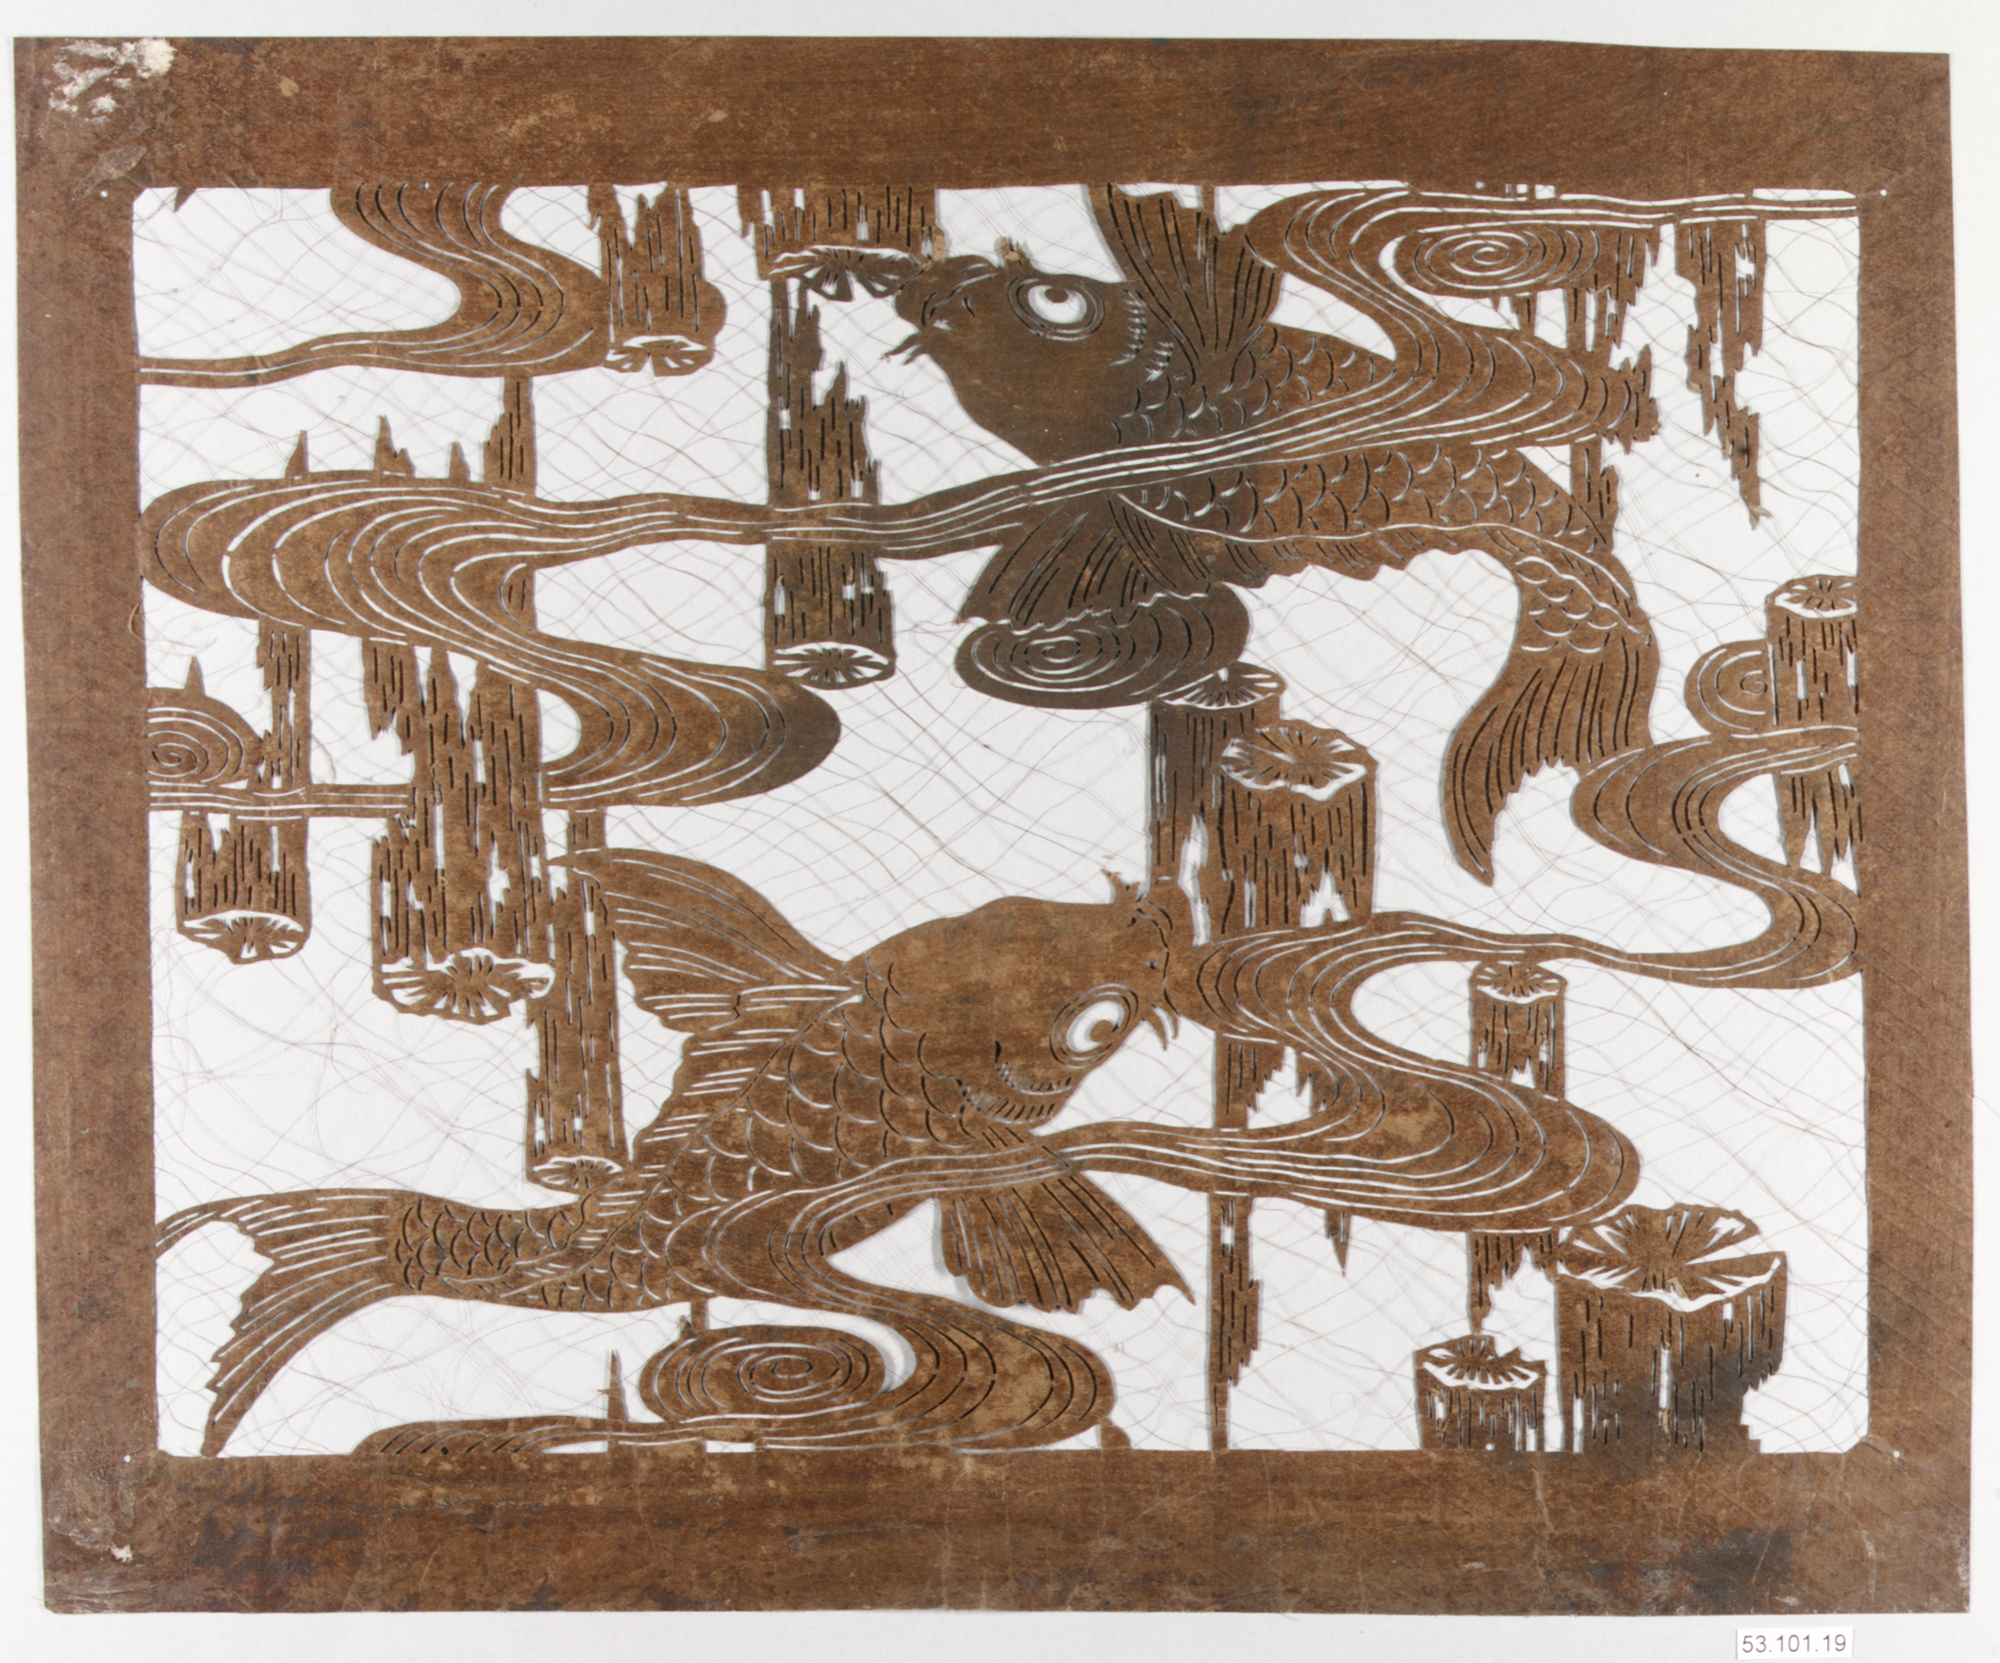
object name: stencil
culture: japanese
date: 1615-1868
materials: paper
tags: fish